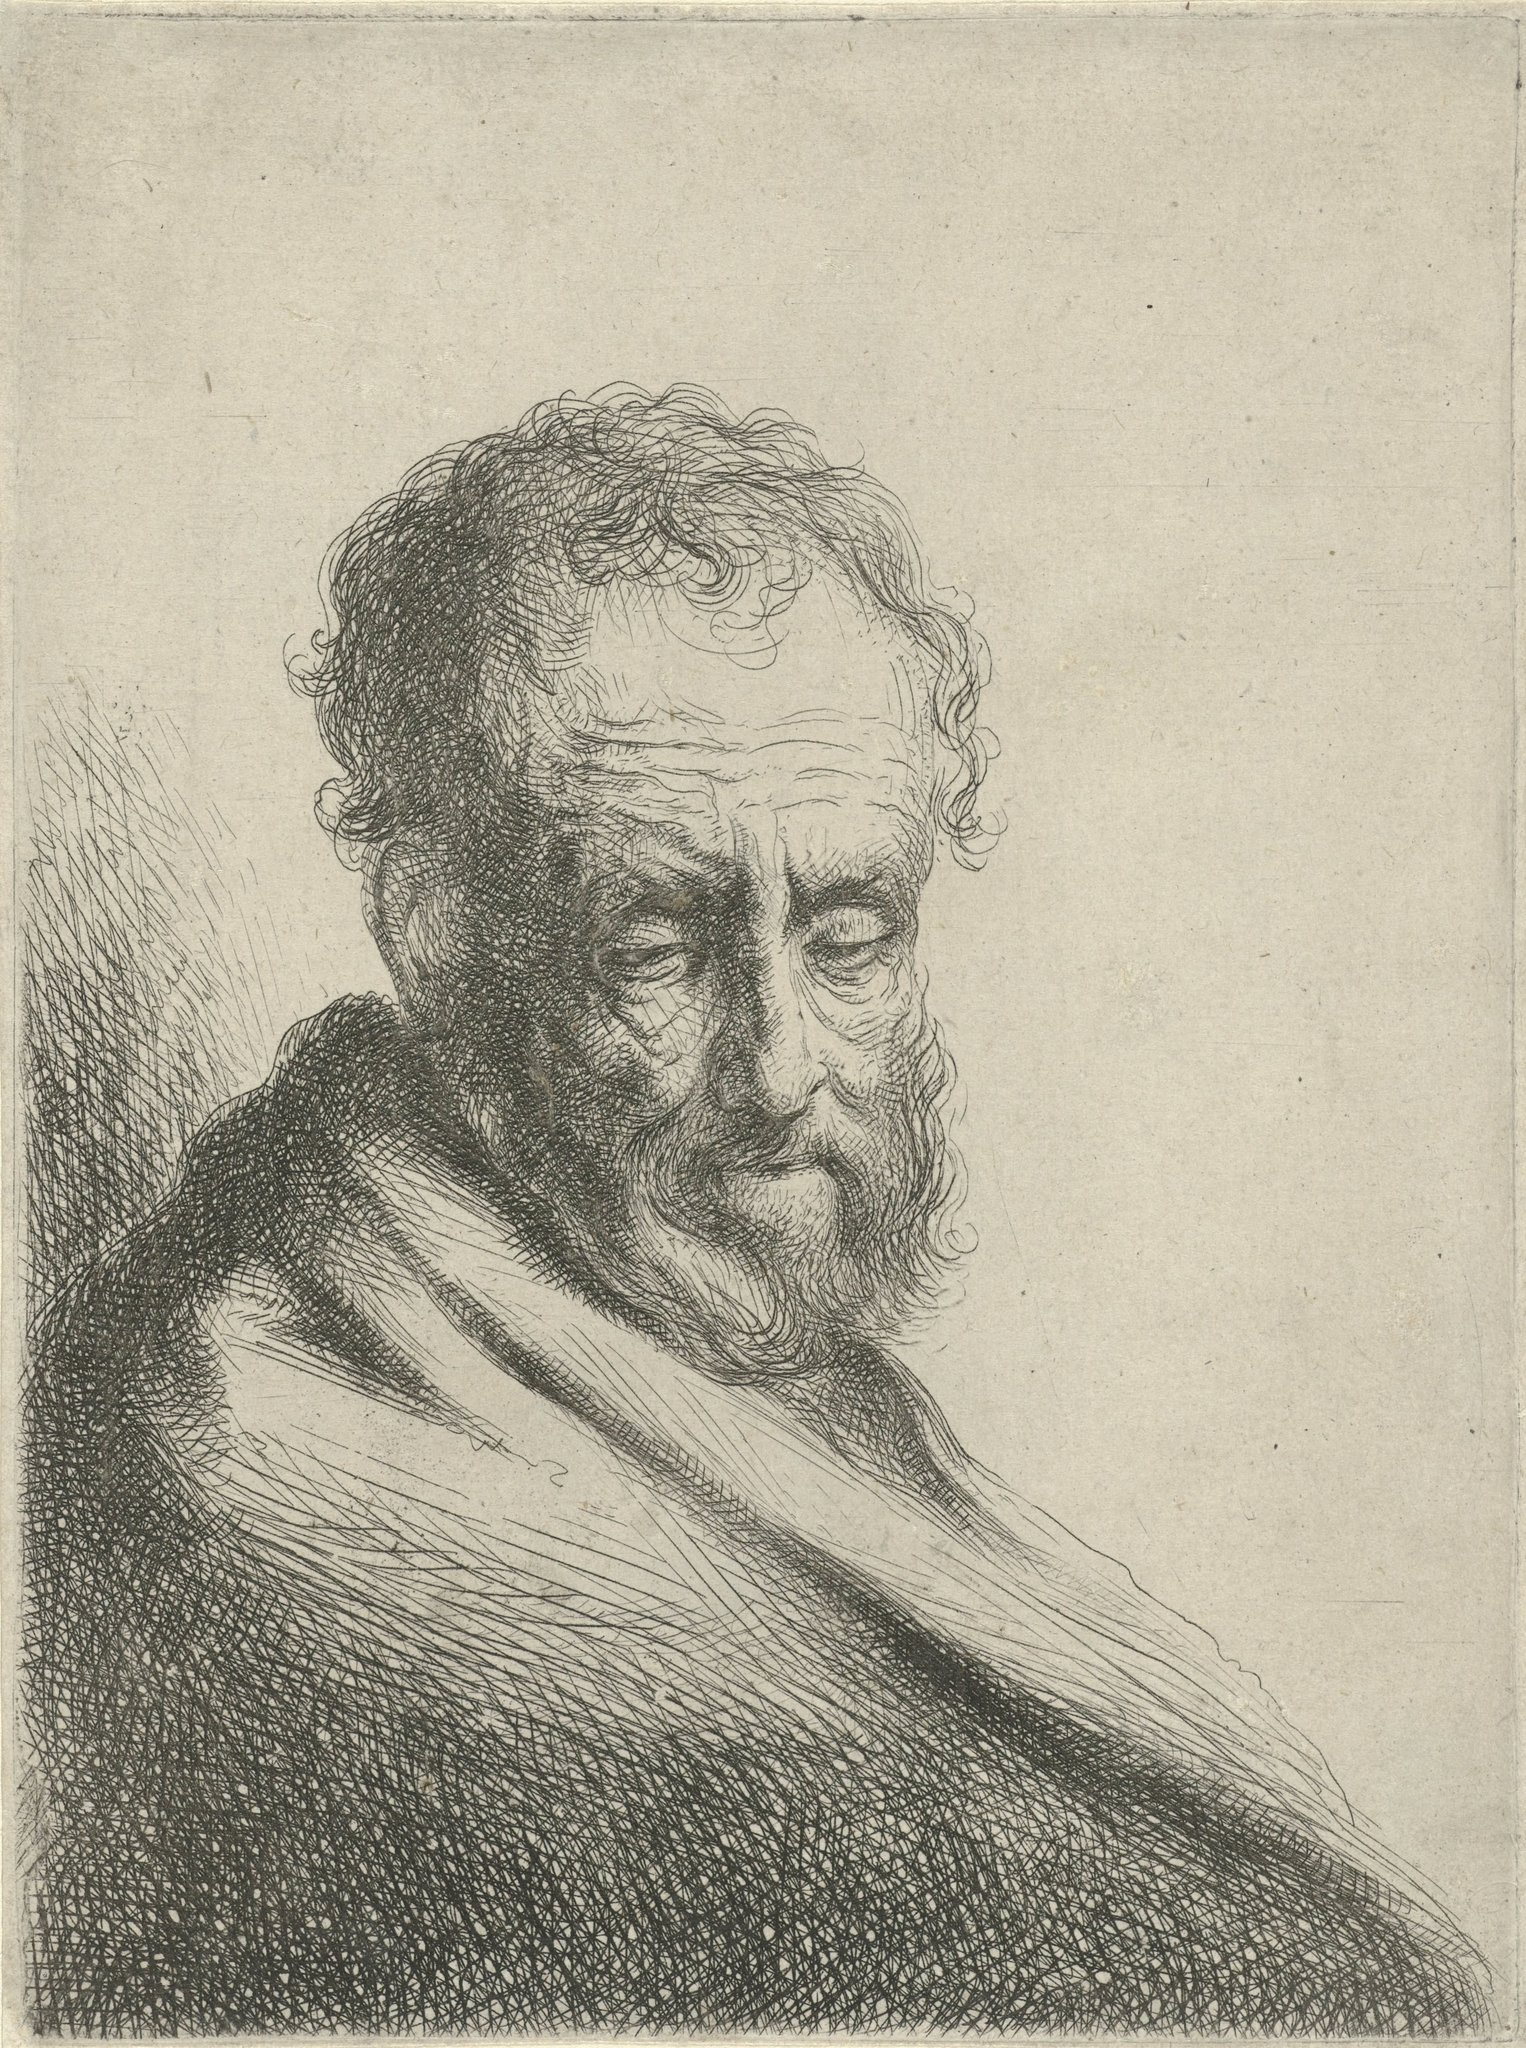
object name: print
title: Buste van een oude man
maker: jan van noordt (1623-1676)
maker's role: draughtsman, painter, print maker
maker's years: 1623-1676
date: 1644-1676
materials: paper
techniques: engraving, etching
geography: amsterdam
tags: old man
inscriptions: collector's mark: Lugt 2760, collector's mark: Lugt 2228, collector's mark: Lugt 33, collector's mark: Lugt 5d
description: Naar een schilderij, eerder toegeschreven aan Rembrandt, in het Ashmolean Museum in Oxford. Vgl. Corpus Rembrandt, deel 1, C31